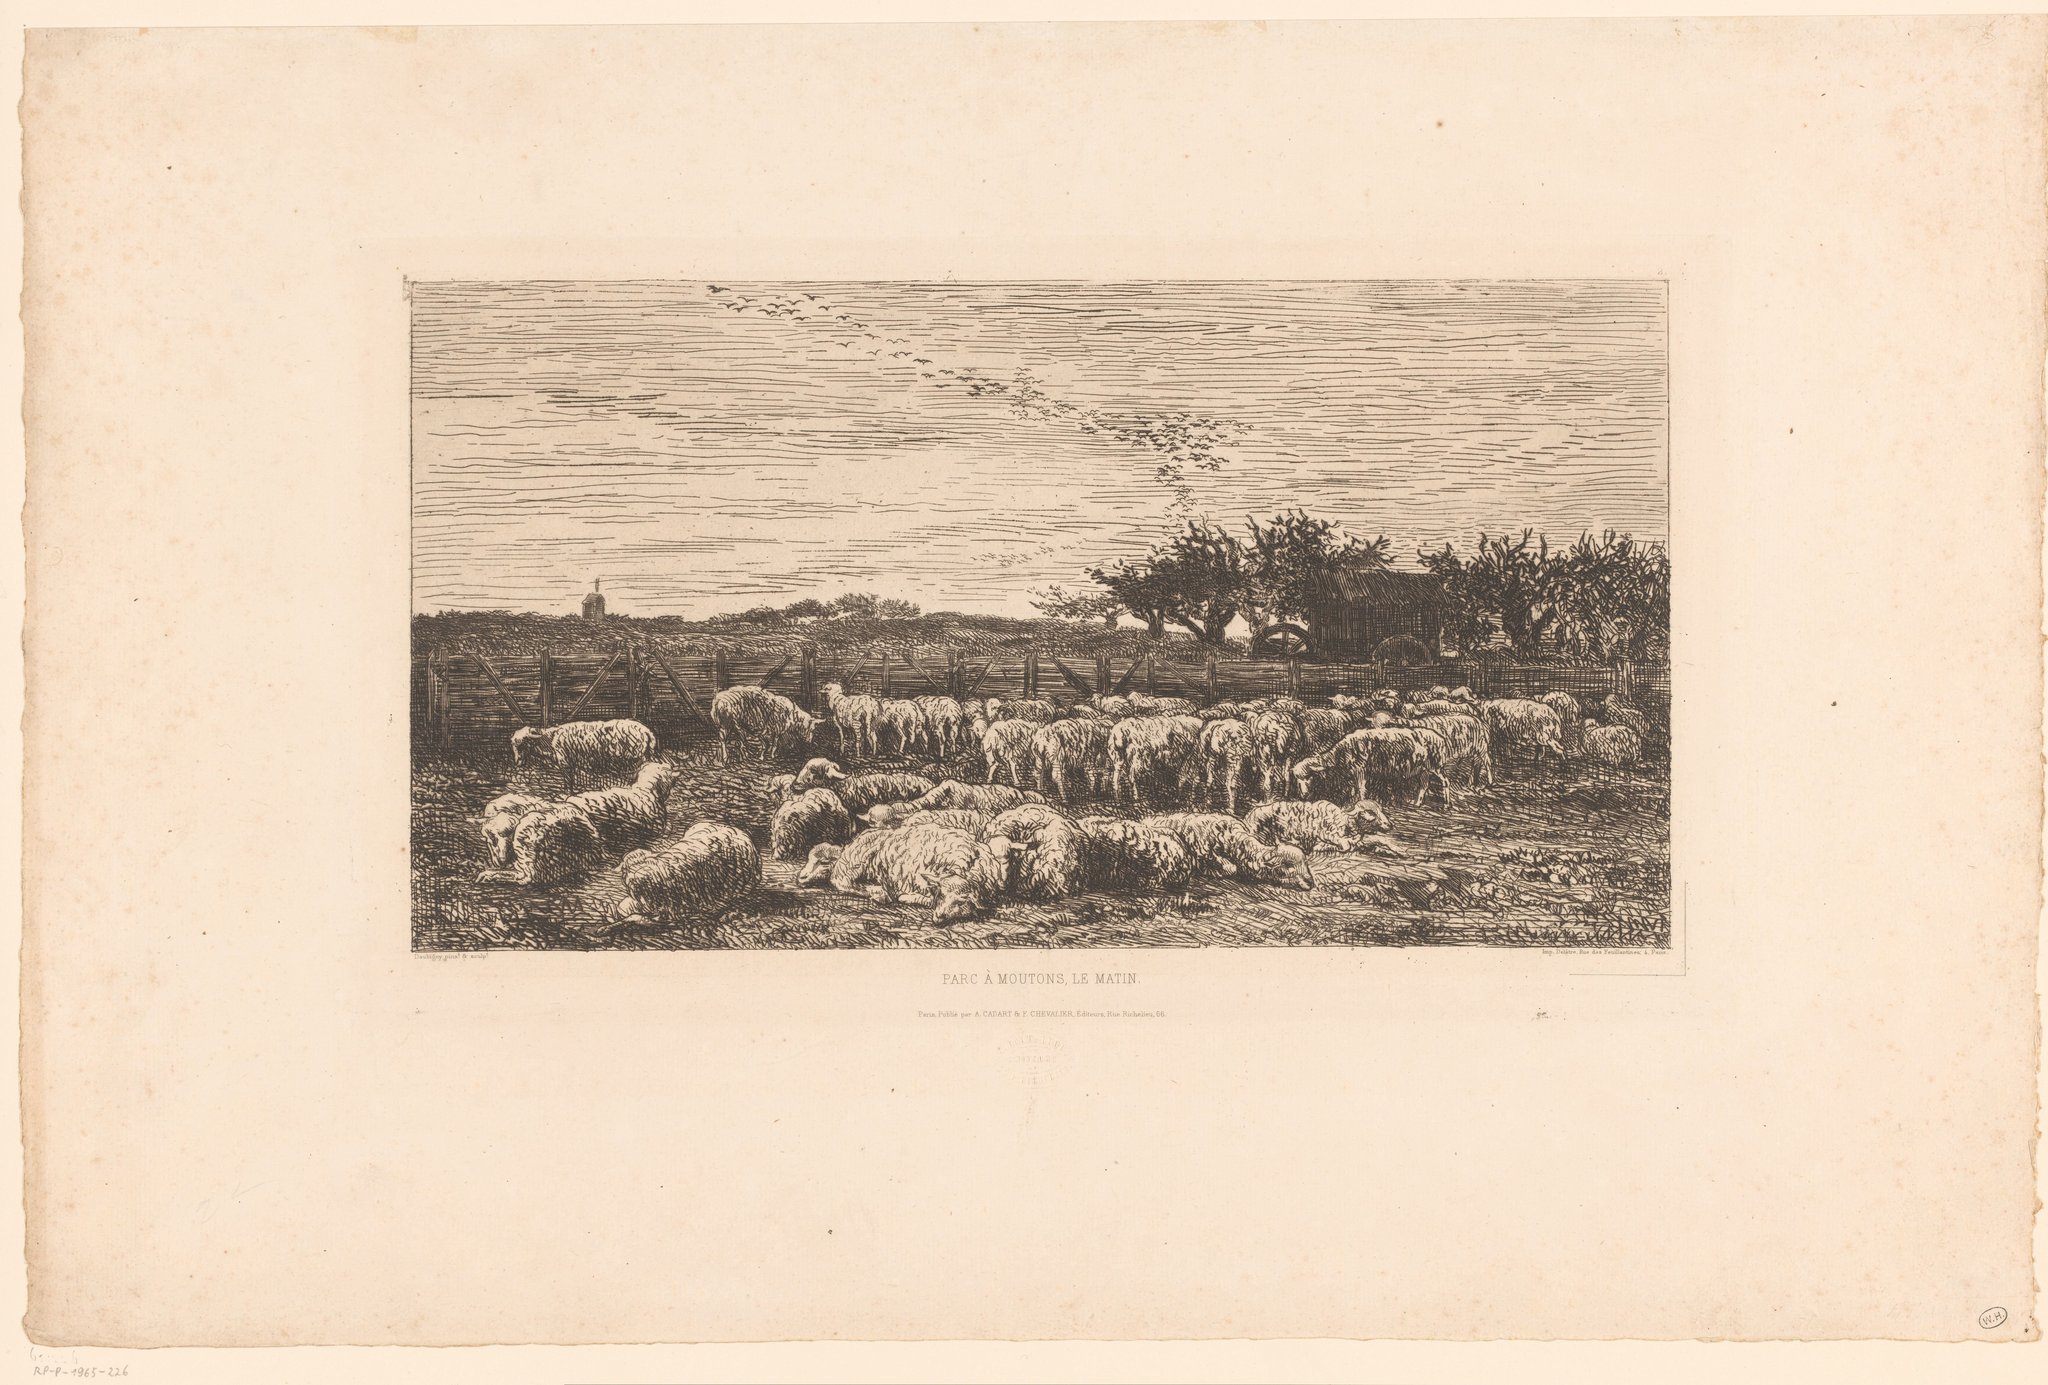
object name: print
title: Landschap met kudde schapen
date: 1862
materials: paper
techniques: drypoint, etching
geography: paris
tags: landscapes, sheep, herd, flock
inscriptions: check stamp: Lugt 424, collector's mark: Lugt 2760, collector's mark: Lugt 2228, collector's mark: Lugt 2625, watermark